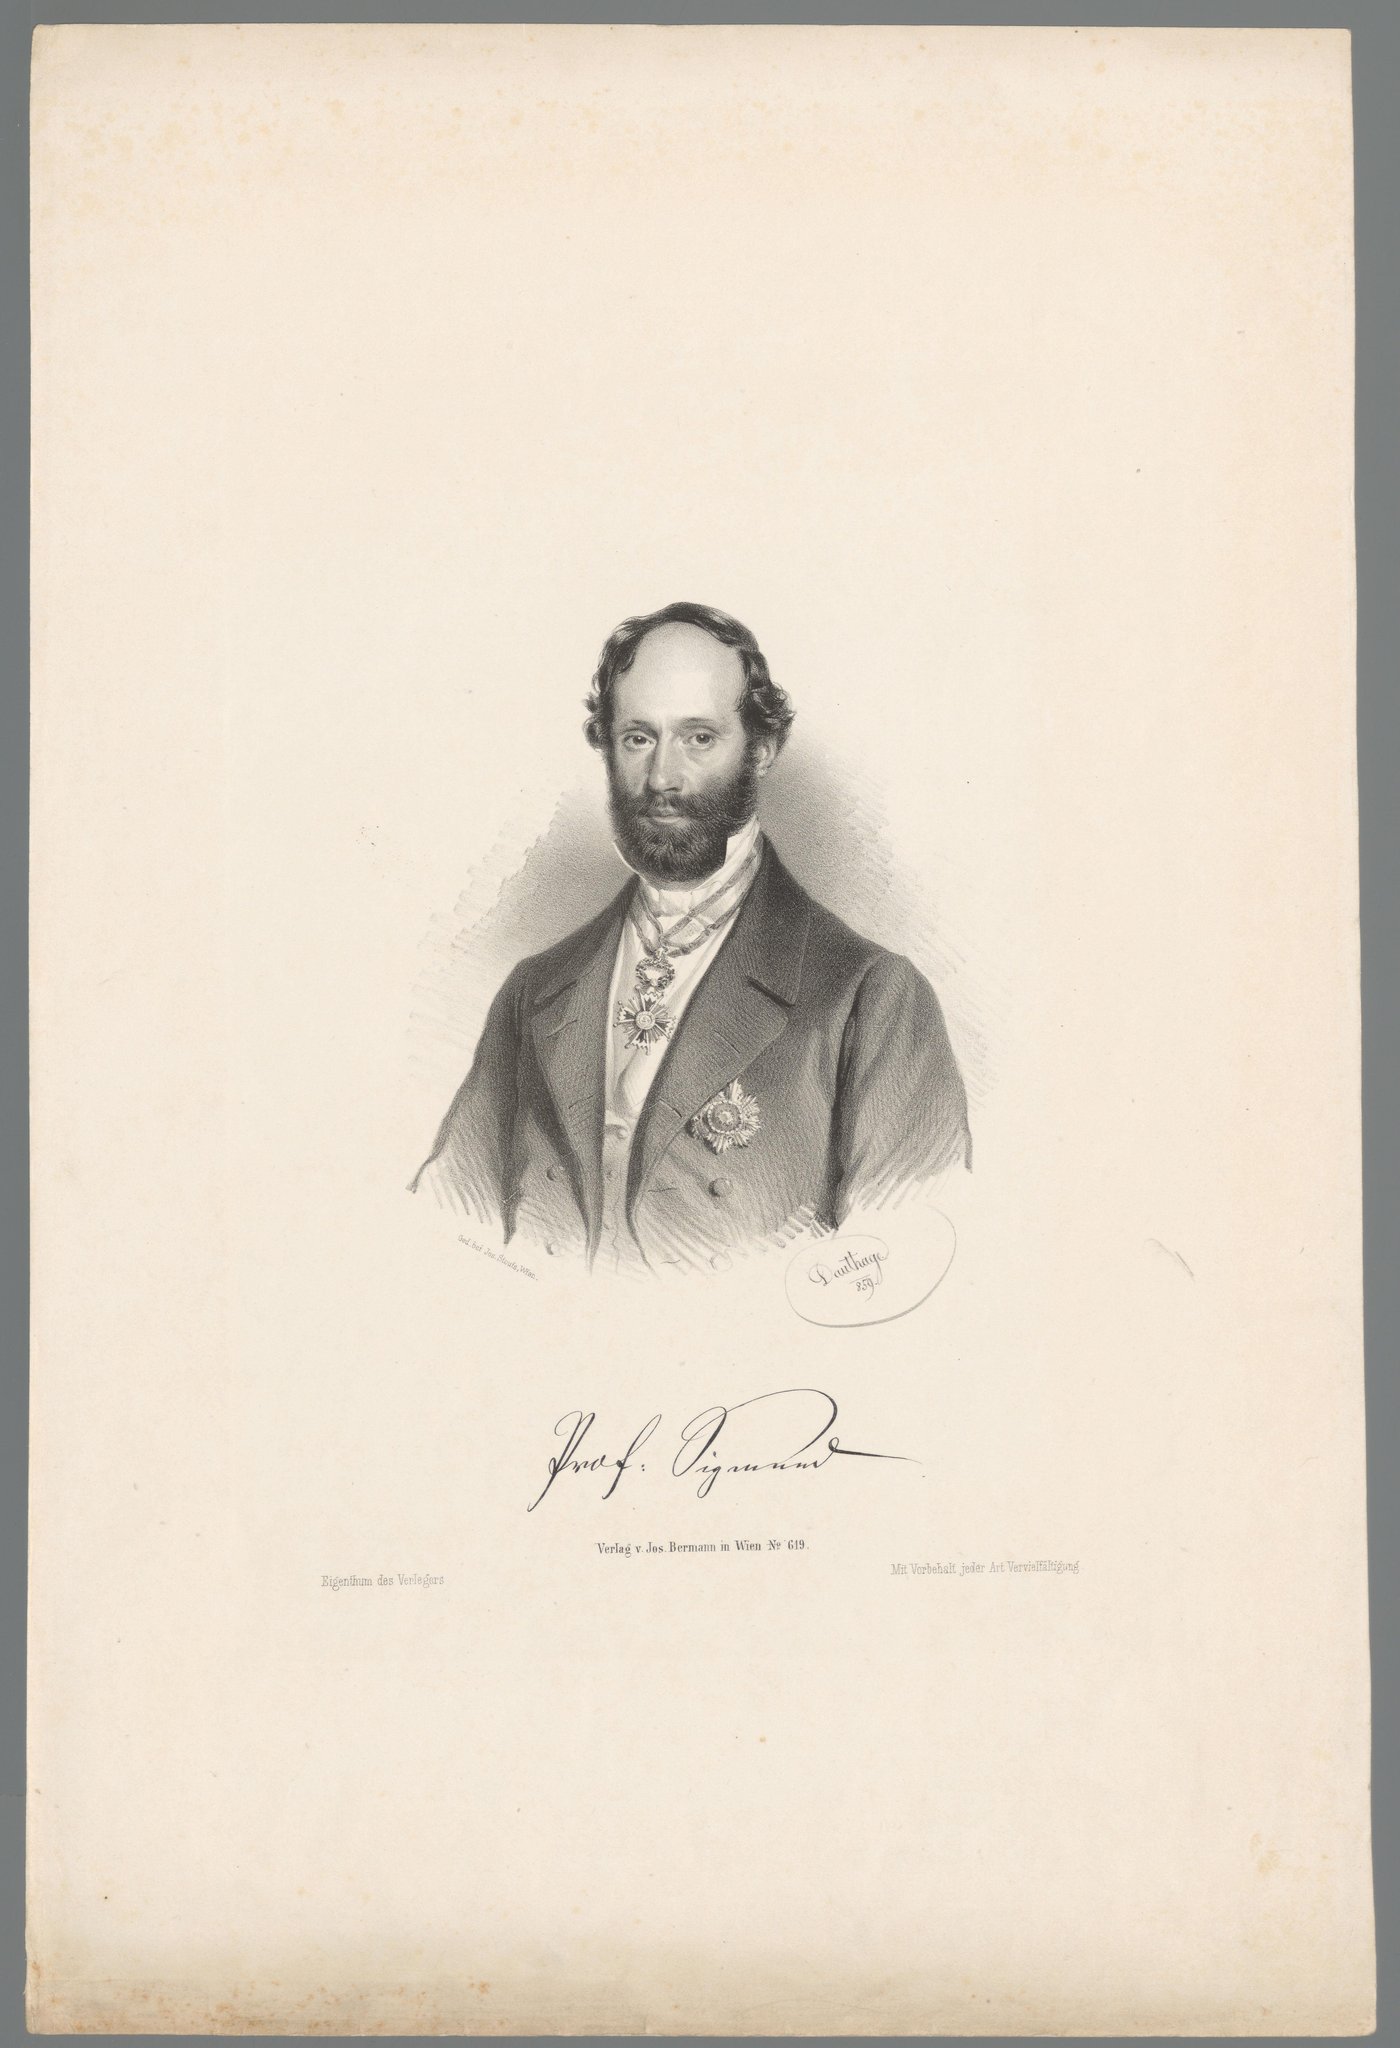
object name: print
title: Portret van Sigmund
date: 1859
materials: paper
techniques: lithograph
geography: vienna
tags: historical persons, professor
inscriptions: collector's mark: Lugt 2228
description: Portret van een verder onbekende professor, met handtekening in facsimile waarin de naam Prof. Sigmund te lezen is.